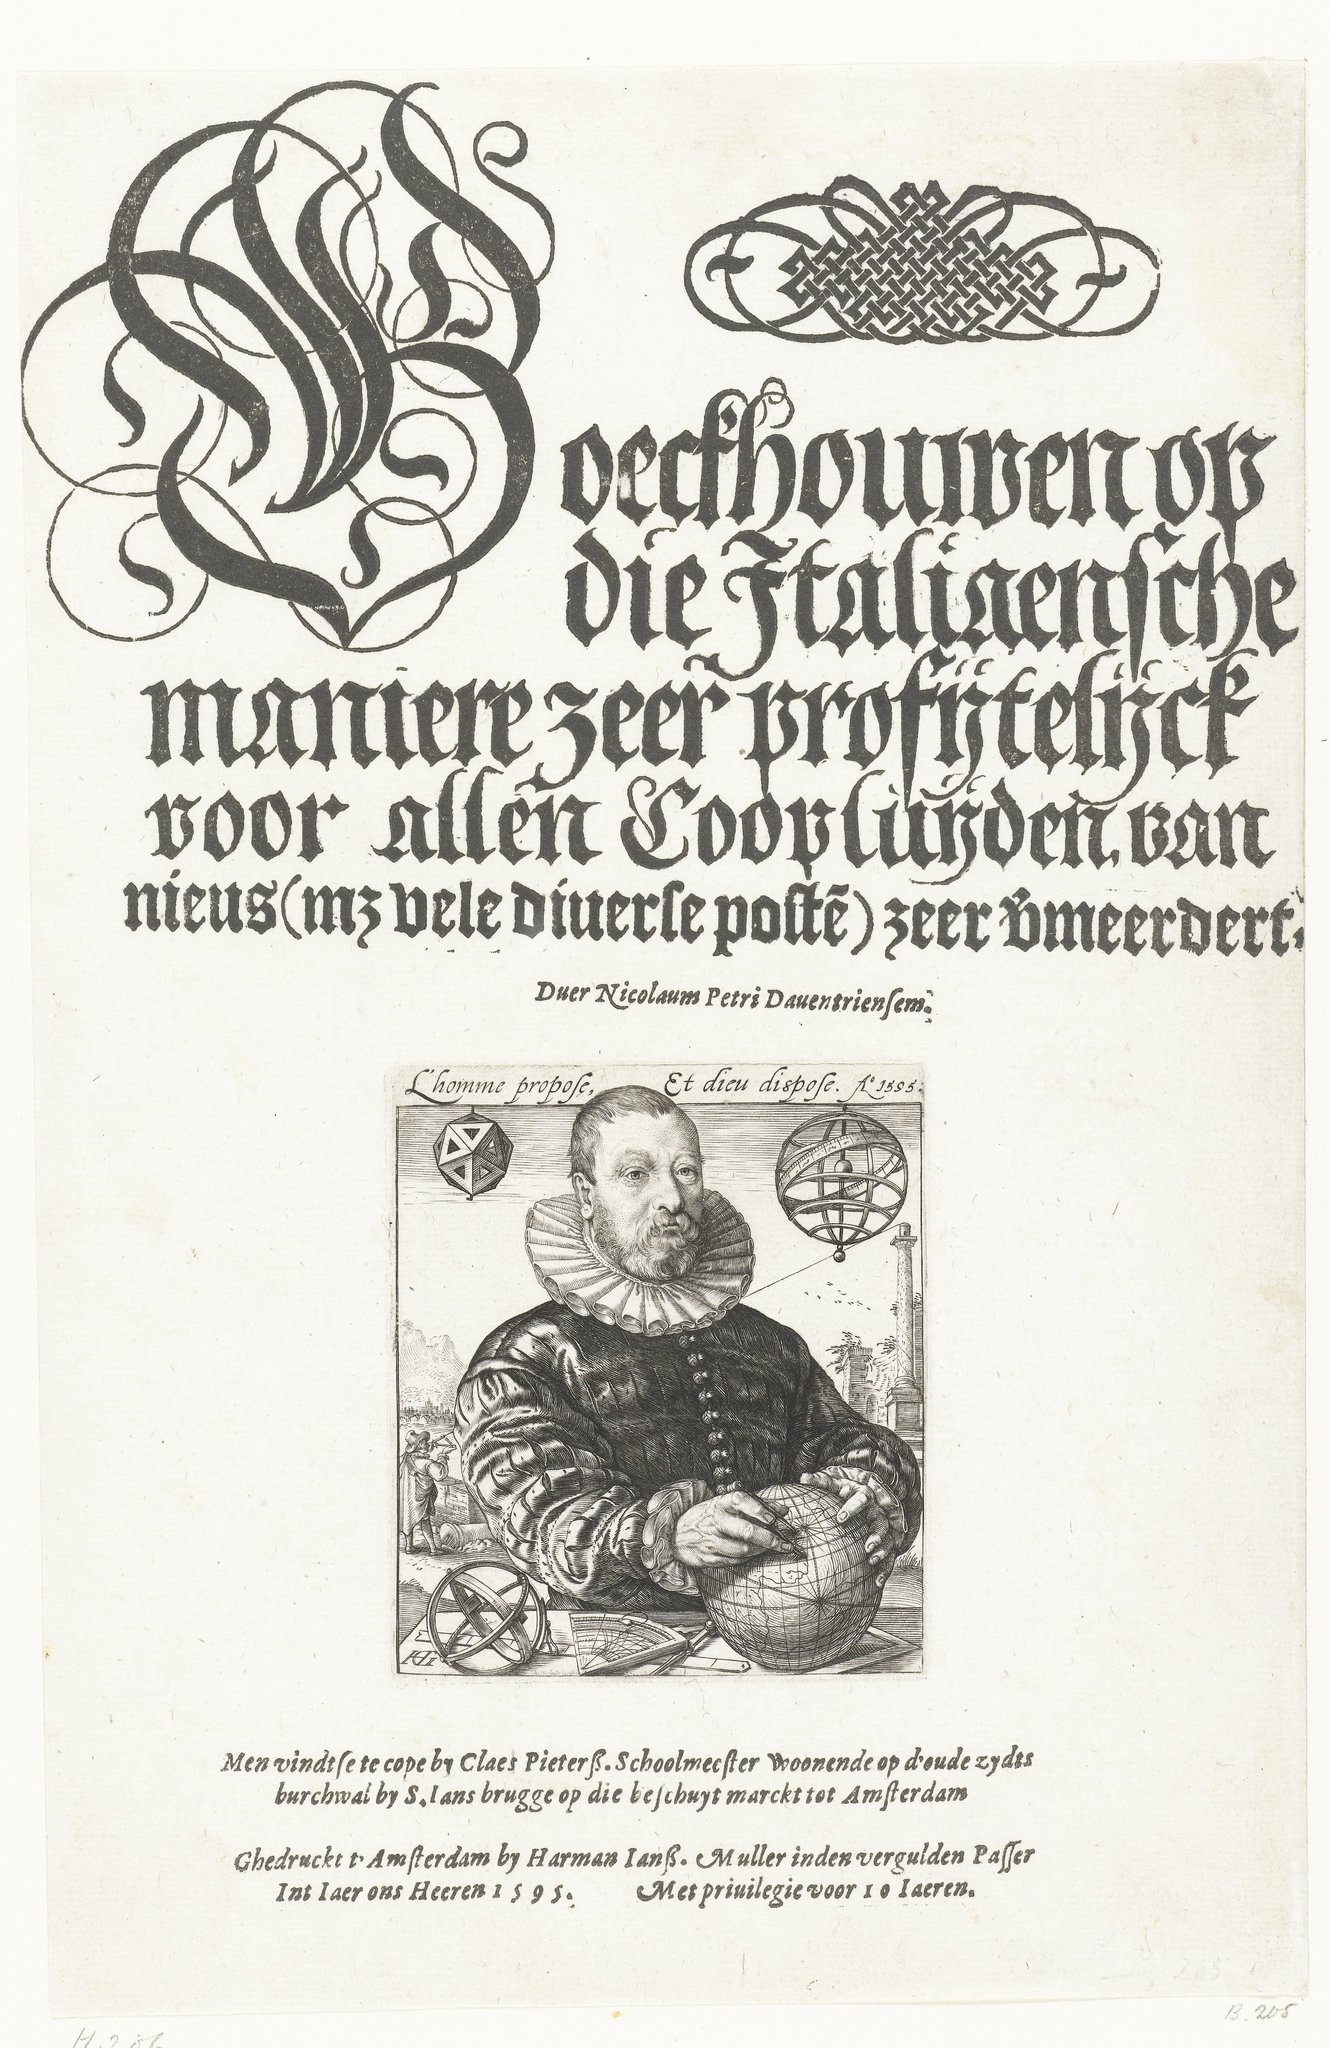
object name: print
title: L'homme propose, Et dieu dispose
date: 1595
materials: paper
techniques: engraving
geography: haarlem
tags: astronomy (and cosmography) (+ portrait of scholar, scientist), historical persons, astronomical instruments, mathematics (+ portrait of scholar, scientist)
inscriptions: privilege: ‘Met privilegie voor 10 Jaeren.’, inscription: ‘L'homme propose, Et dieu dispose.’, address and date: ‘Ghedruckt t' Amsterdam bij Harman Janss. Muller in den vergulden Passer Int Jaer ons Heeren 1595.’, monogram: ‘HG’, date: ‘Ao 1595’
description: Portret van Nicolaus Petri van Deventer, rekenmeester en astronoom in Amsterdam. Portret ten halven lijve, achter een tafel waarop mathematische en astronomische instrumenten: globe, hemelsfeer, astrolabium, passer. Links van zijn hoofd een geometrisch figuur, rechts een hemelsfeer. Man links op de achtergrond richt een meetinstrument op de obelisk rechts op de achtergrond. De prent is hier gebruikt voor het titelblad van Petri's boek 'Boekhouwen op die Italiaensche manier...', uitgegeven door Harman Jansz. Muller te Amsterdam in 1595.